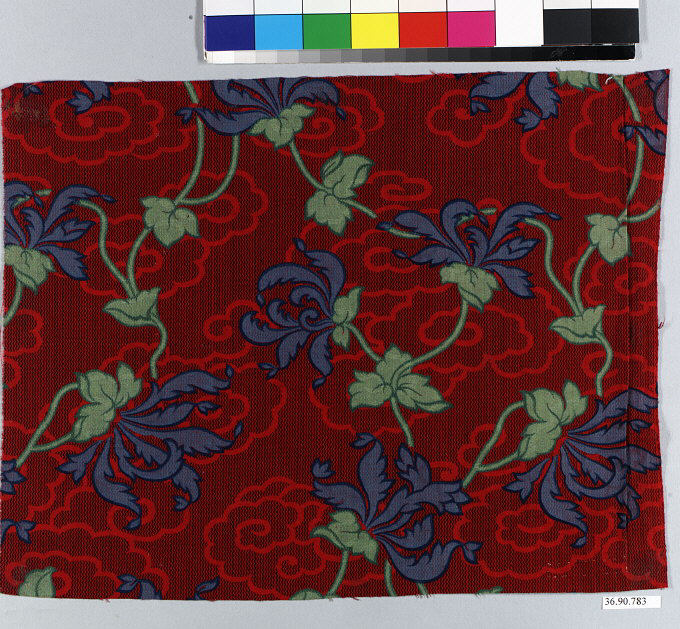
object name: piece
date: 1867-1900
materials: cotton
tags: flowers,leaves